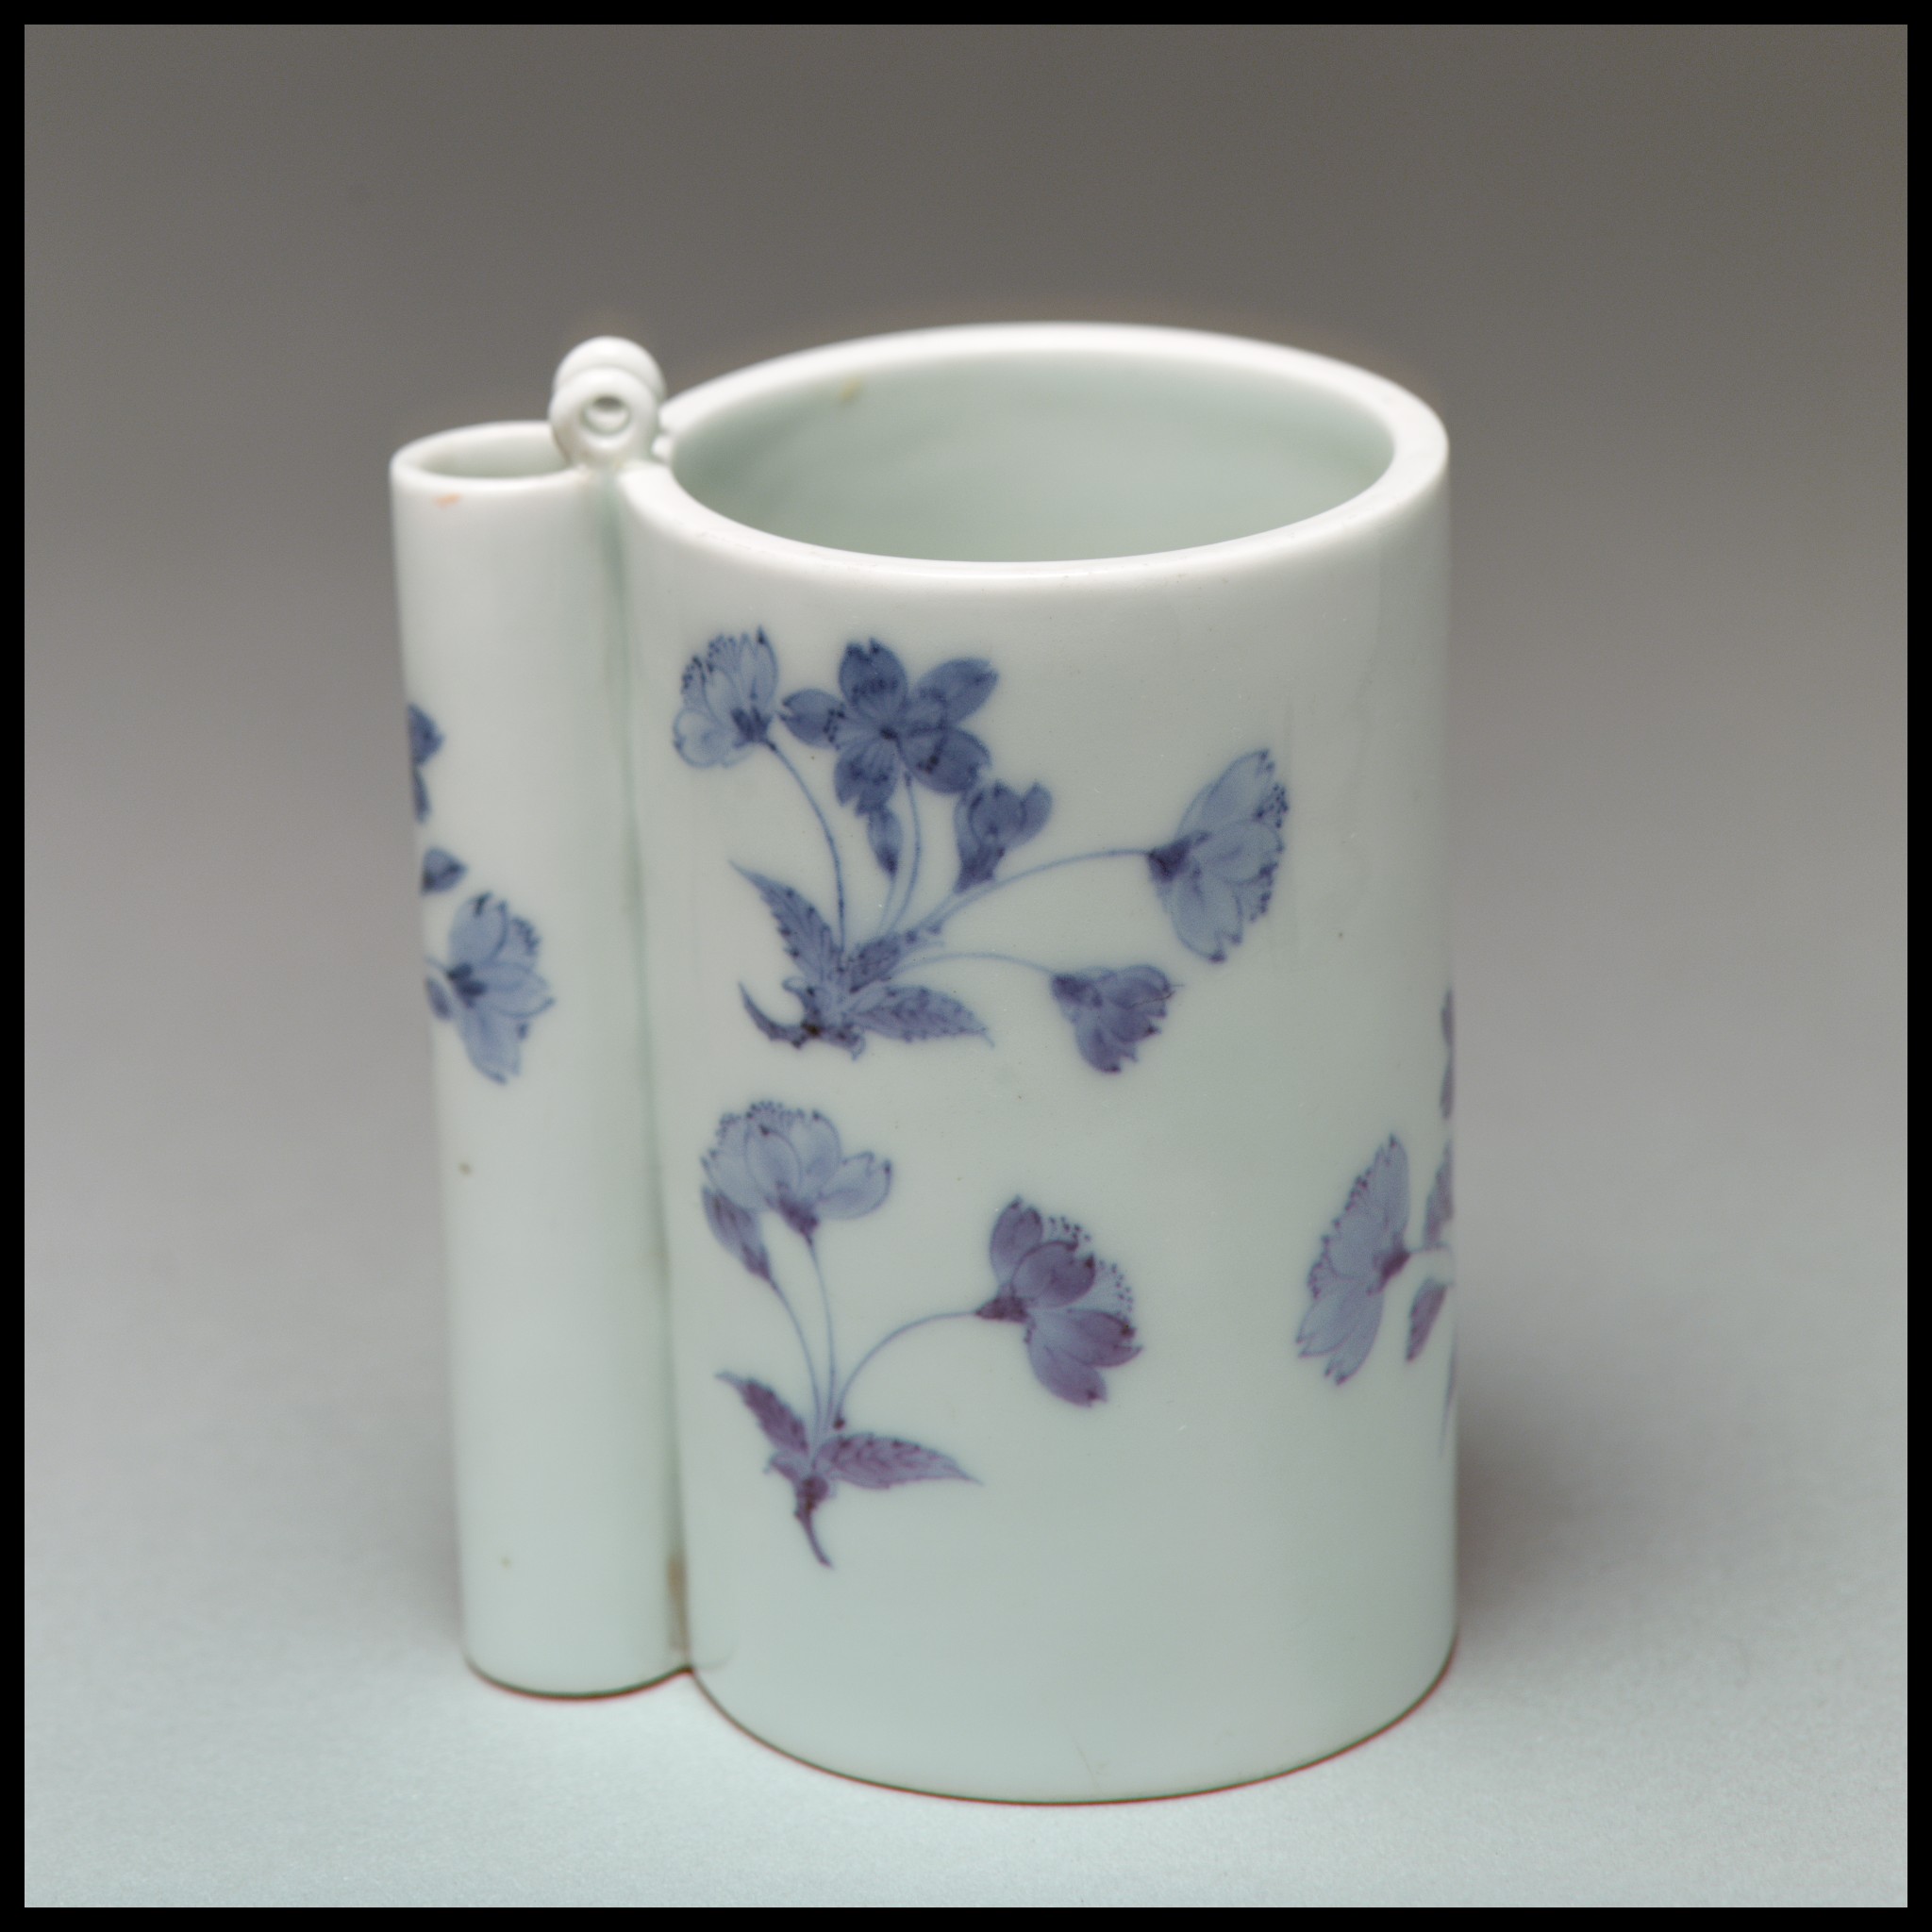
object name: brush holder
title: Brush Holder in form of a bird-feeding vessel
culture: japanese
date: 1800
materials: glaze, porcelain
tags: flowers